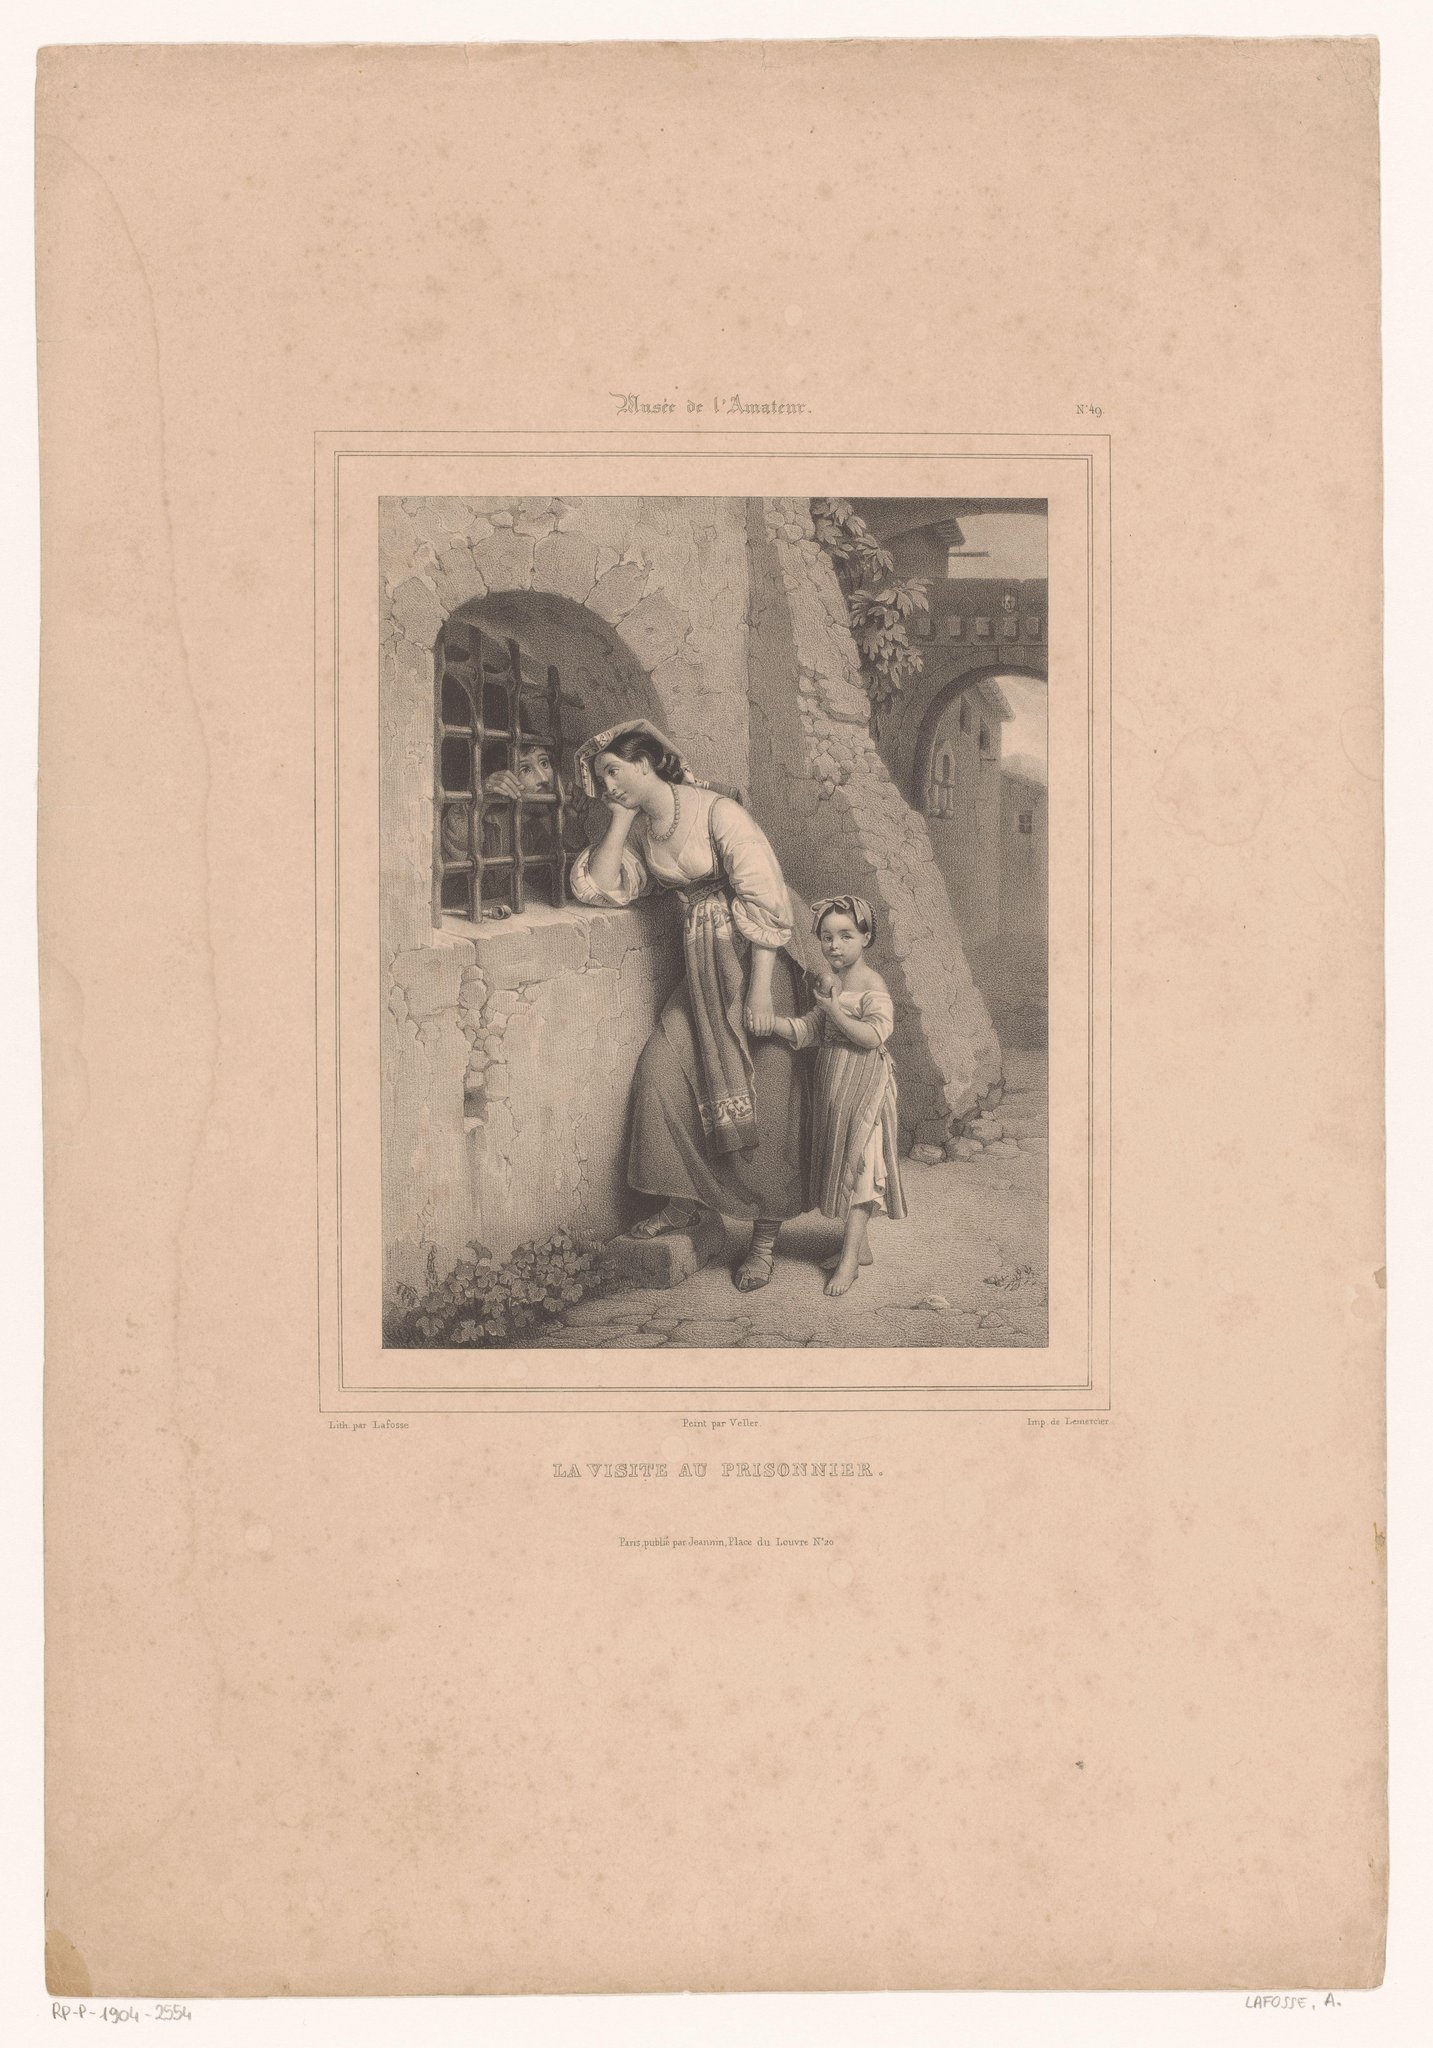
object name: print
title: La visite au prisonnier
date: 1836-1842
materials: paper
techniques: lithograph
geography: paris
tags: visit to prison or penal camp, mother and child(ren), woman and child(ren) (family group), prisoner in cell or locked place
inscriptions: check stamp: Lugt 1397c, collector's mark: Lugt 2228a